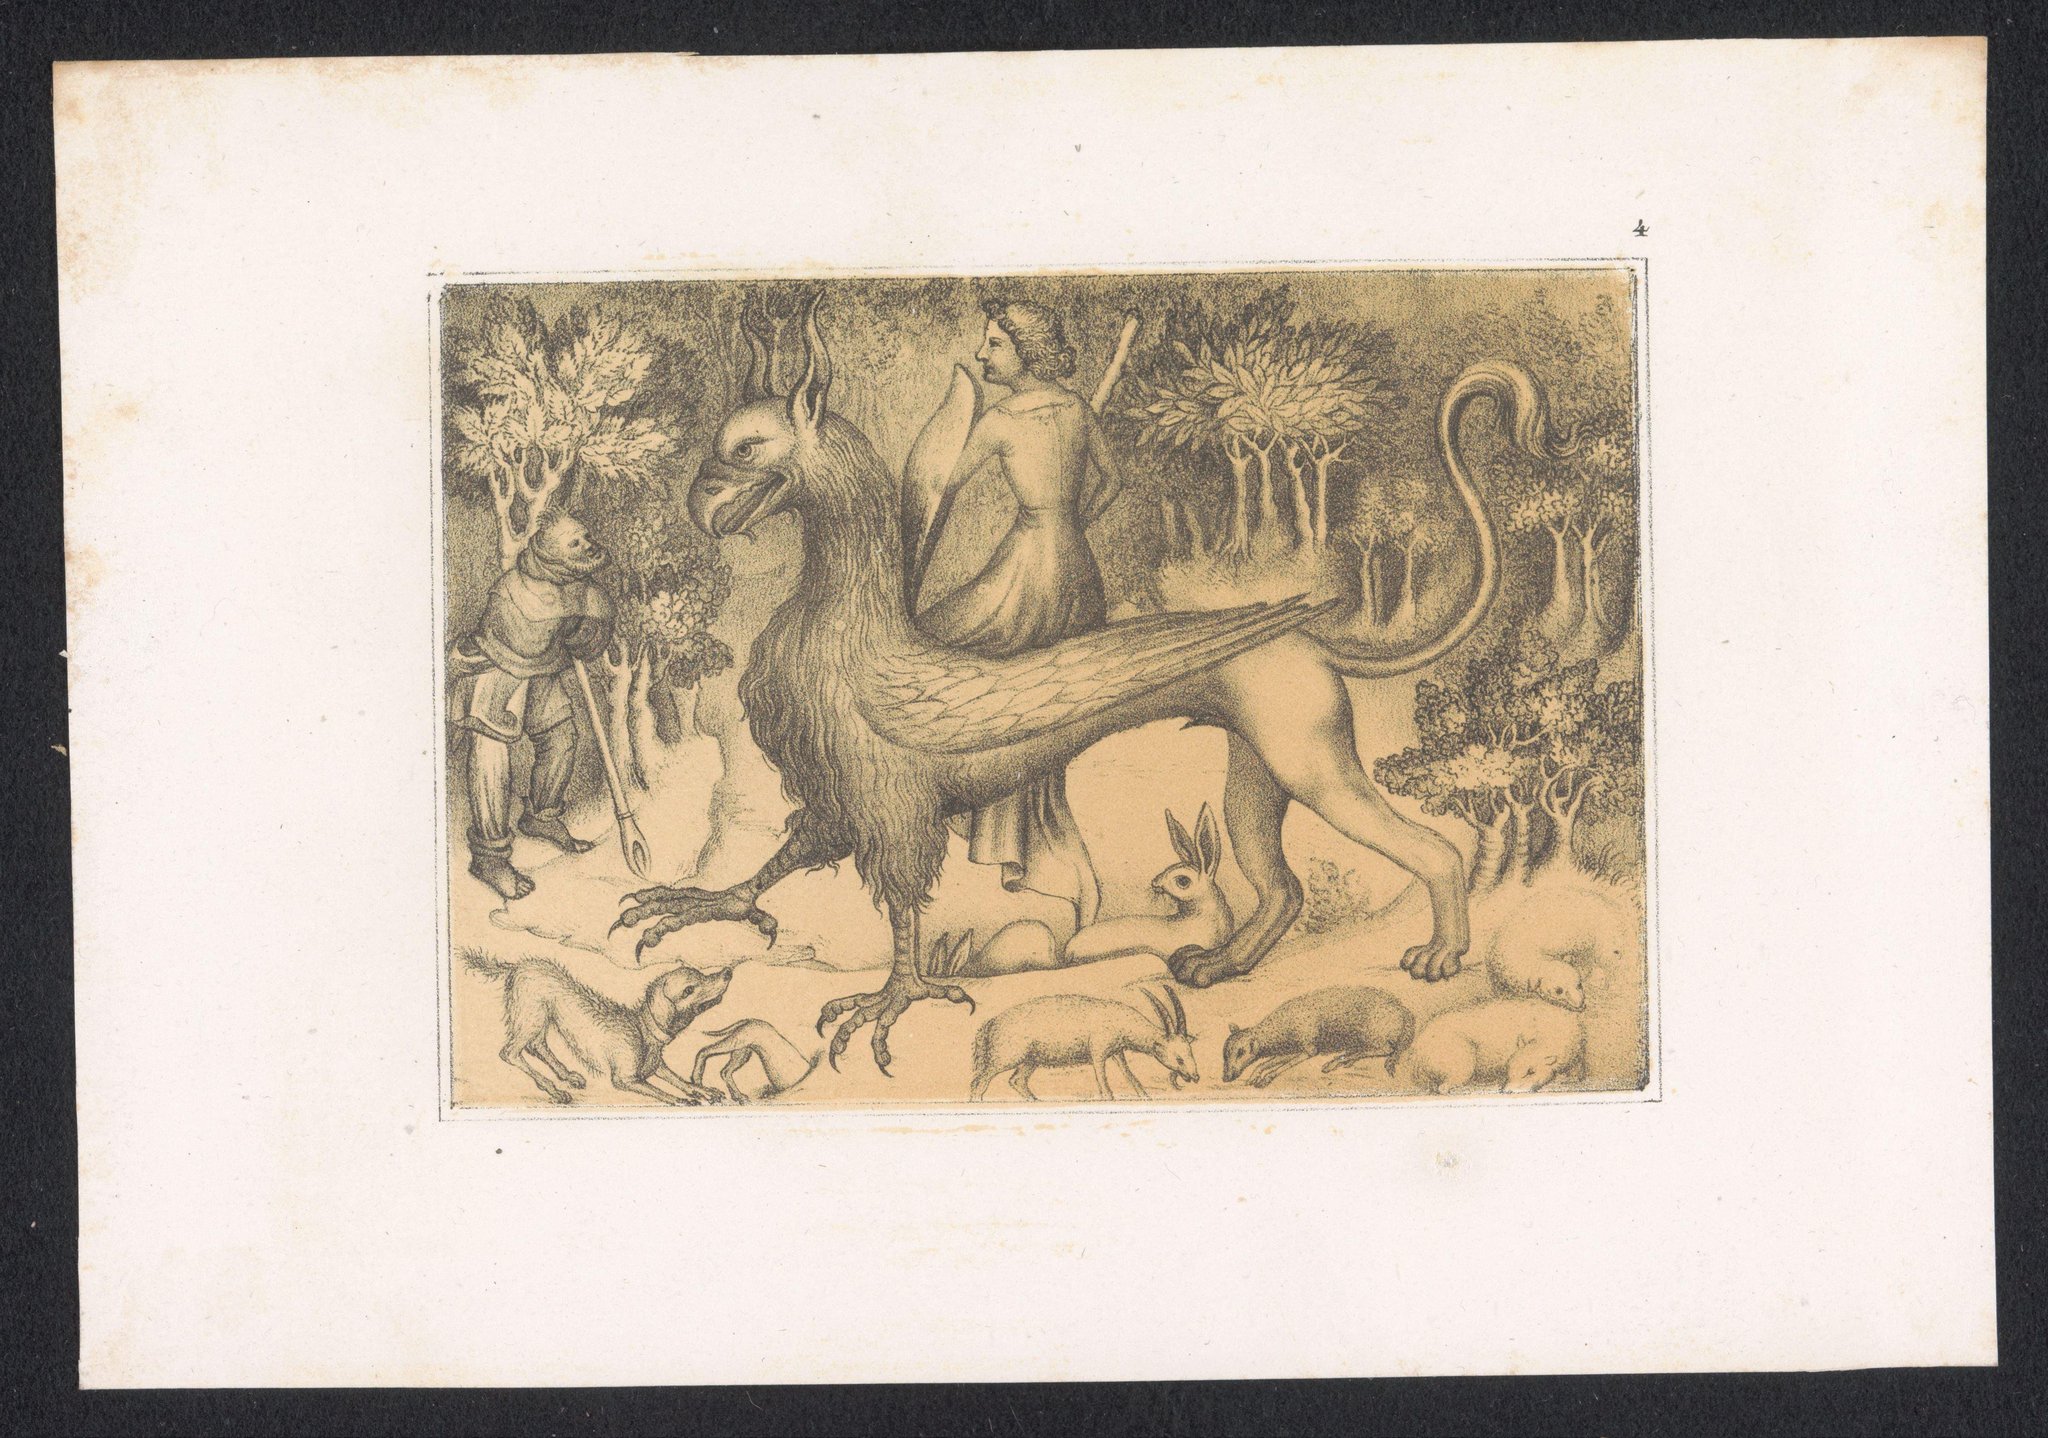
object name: print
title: Vrouw zittend op griffioen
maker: karl palzow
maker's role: print maker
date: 1830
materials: paper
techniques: tone lithography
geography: berlin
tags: griffin (lion/eagle); 'griffo' (ripa), riding on animal other than horse, ass, or mule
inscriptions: collector's mark: Lugt 2228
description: Een jonge vrouw met schild en lans zit in amazonezit op de rug van een griffioen. In het bos rondom staan een oude herder en diverse dieren. Prent is onderdeel van een omslag met tekst en een serie van achttien lithografieën naar schilderijen van Nederlandse meesters.